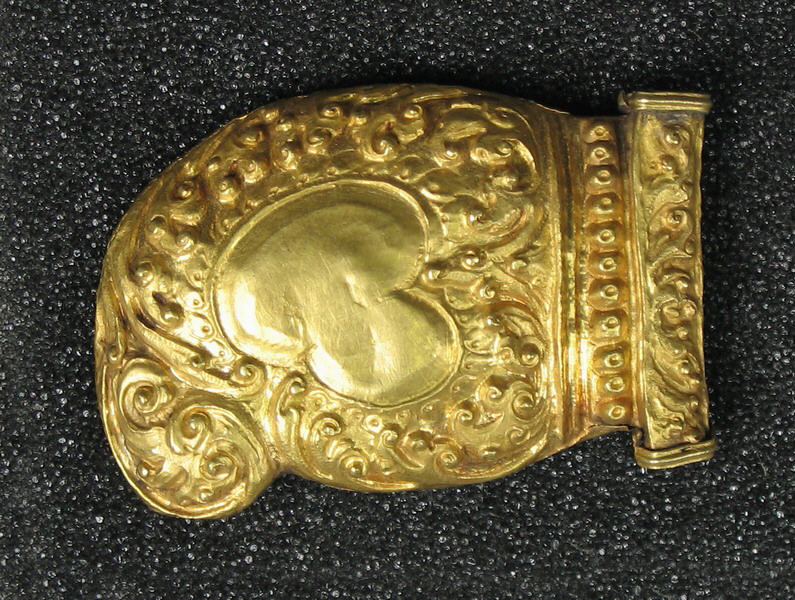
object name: pendant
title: Tiger Claw Pendant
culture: indonesian, central java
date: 701-1200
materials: gold